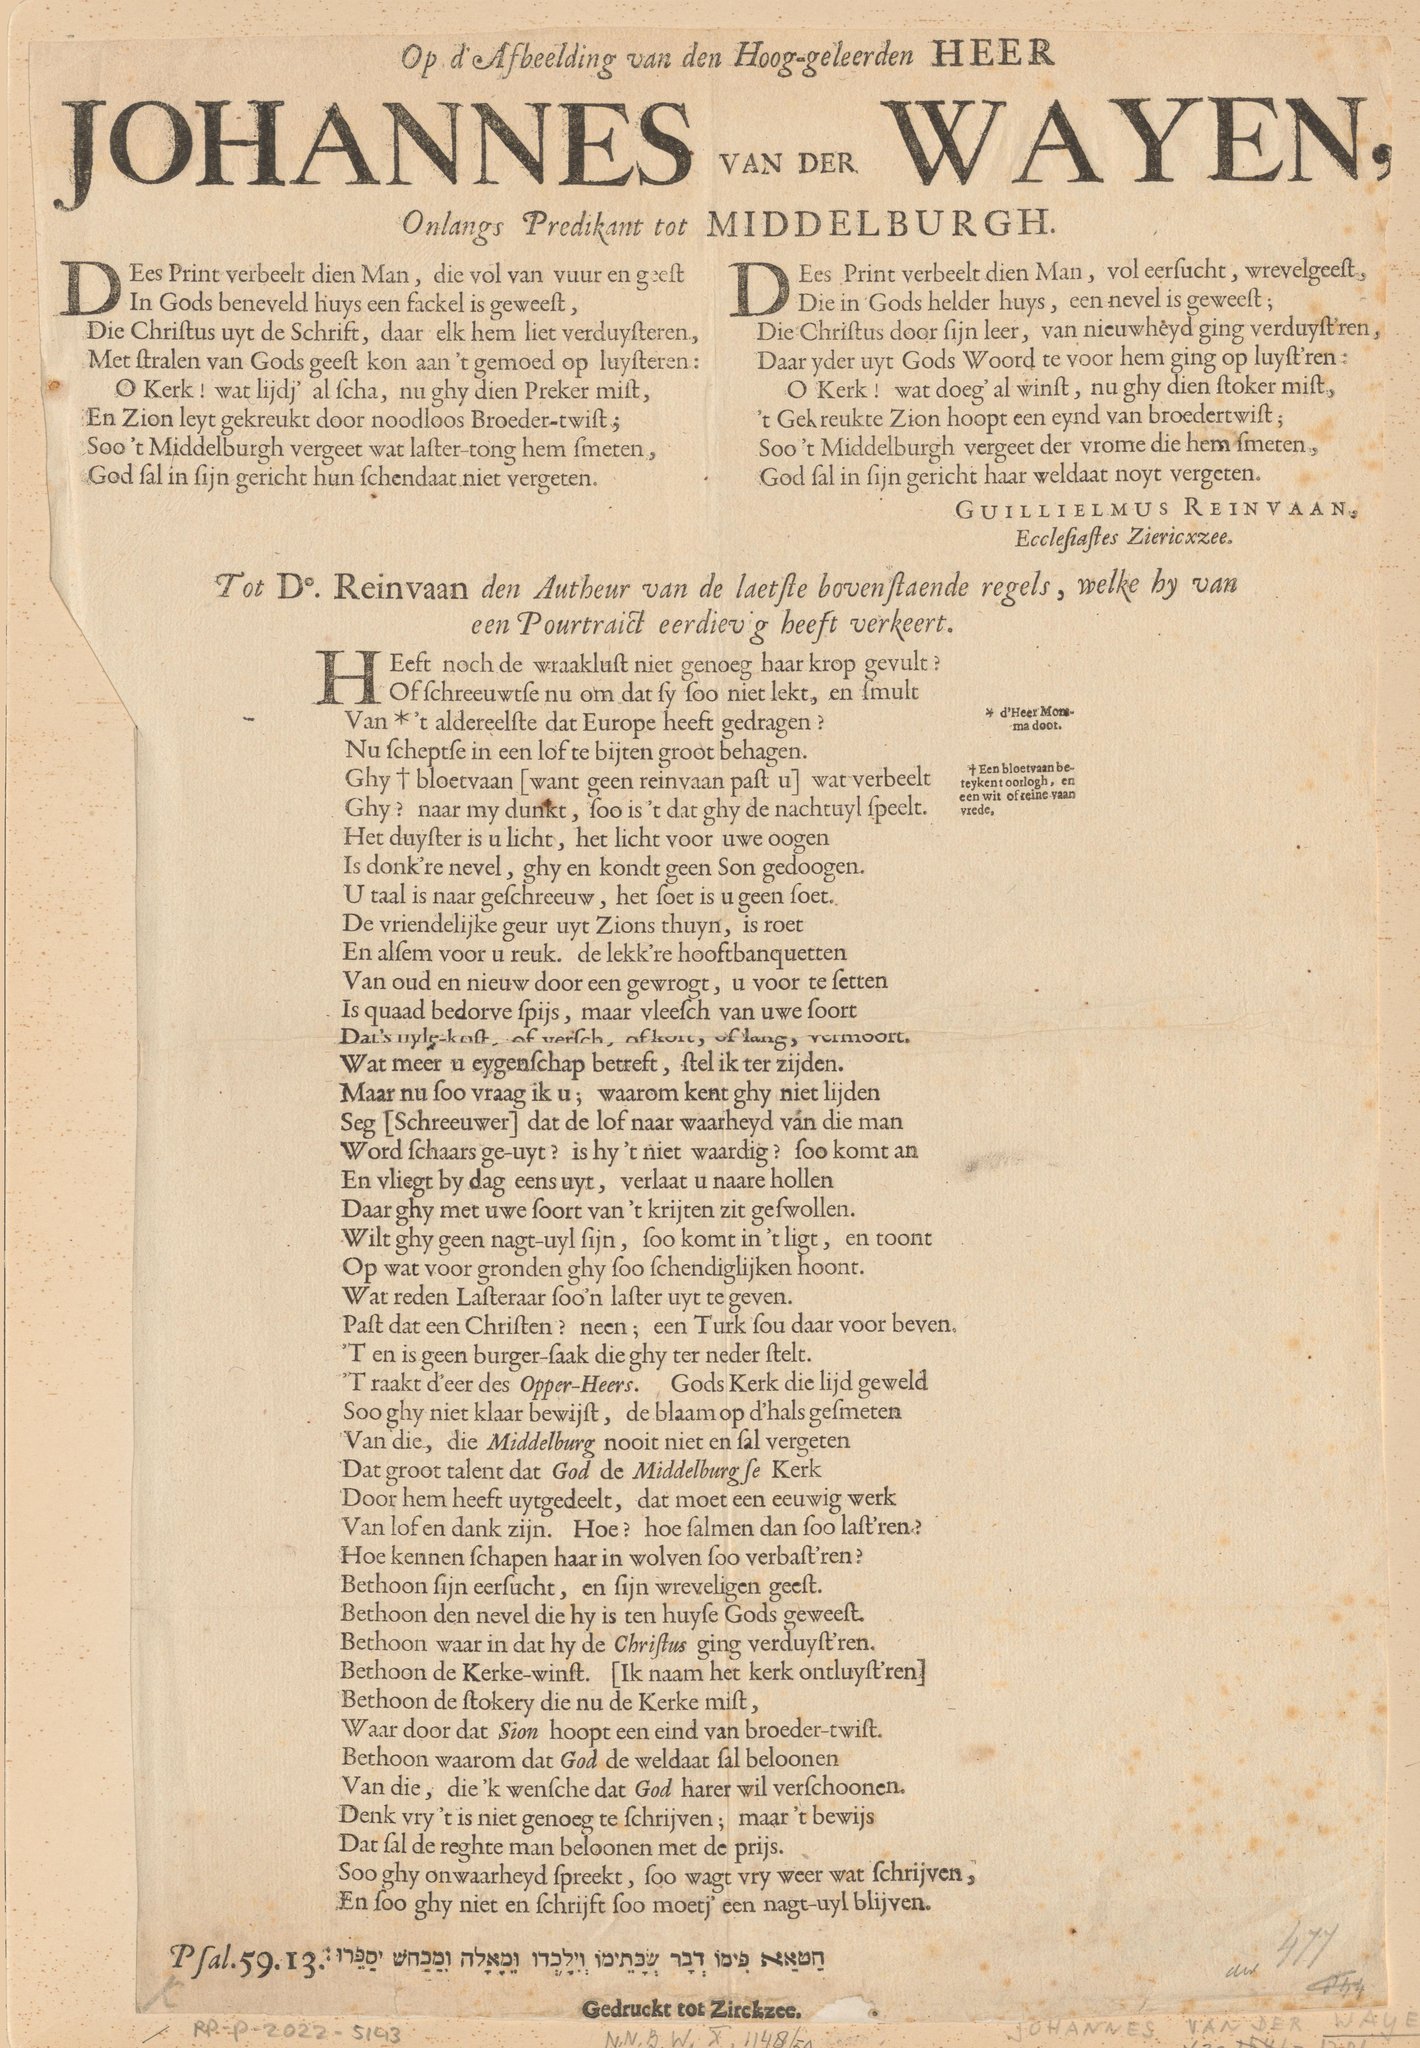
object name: text sheet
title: Gedicht bij een portret van Johannes van der Waeyen op zijn overlijden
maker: guillielmus reinvaan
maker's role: predikant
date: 1701-1704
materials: paper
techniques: letterpress printing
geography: zierikzee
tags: franeker, predikant, johannes van der waeyen